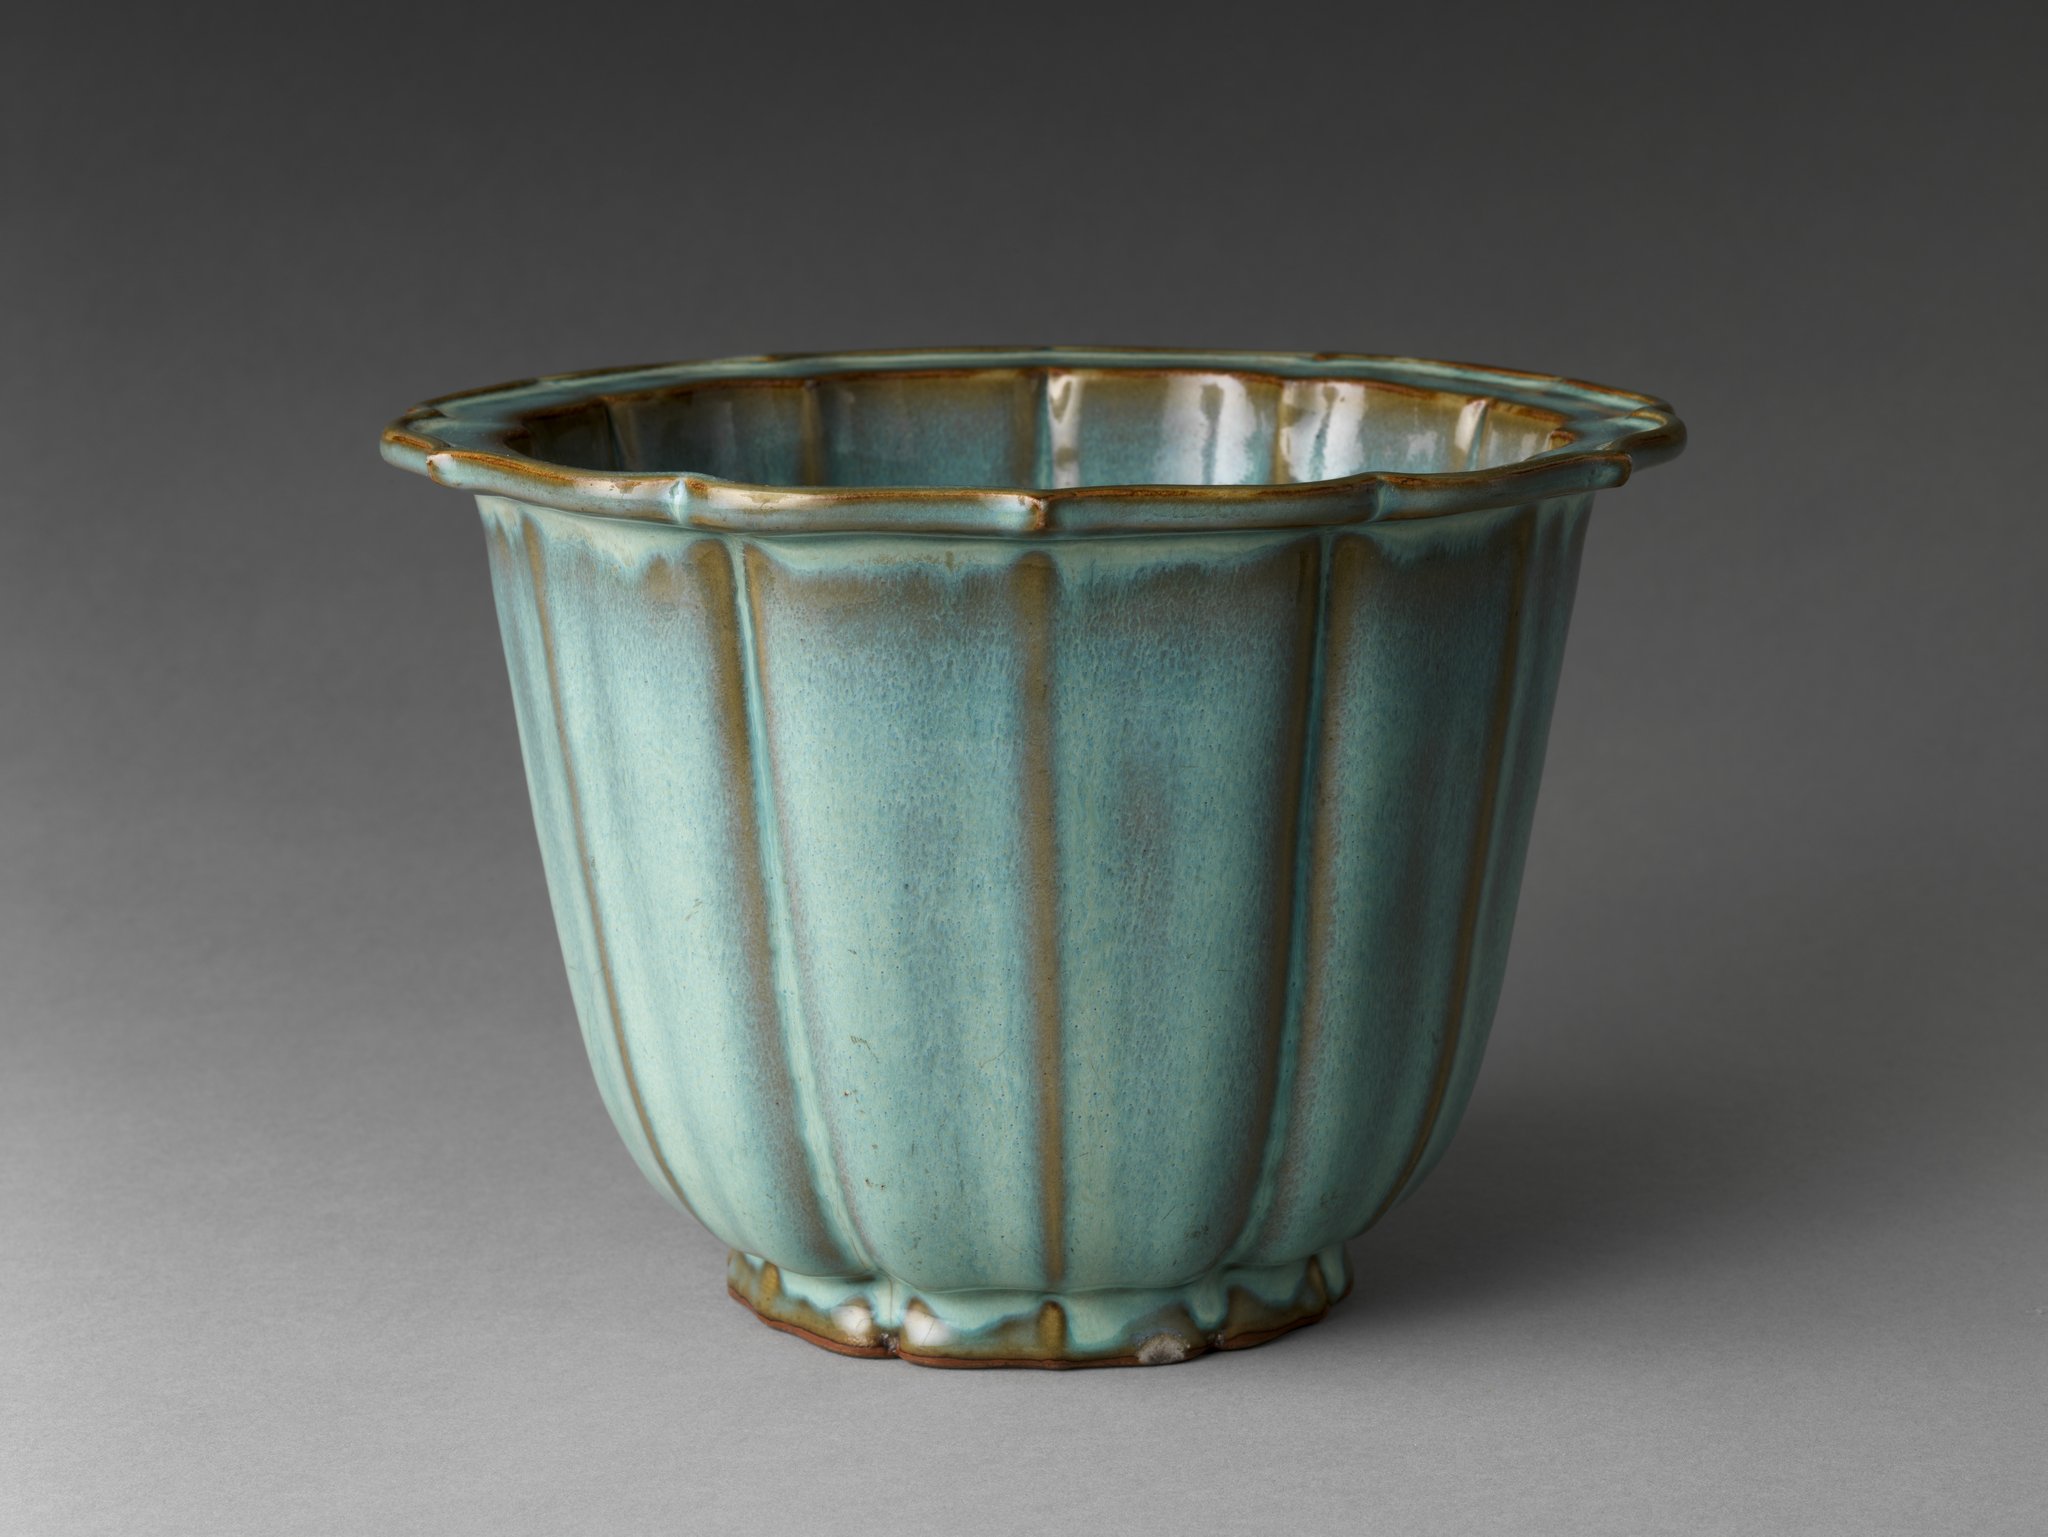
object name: water dropper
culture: chinese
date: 1101-1300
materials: glaze, stoneware